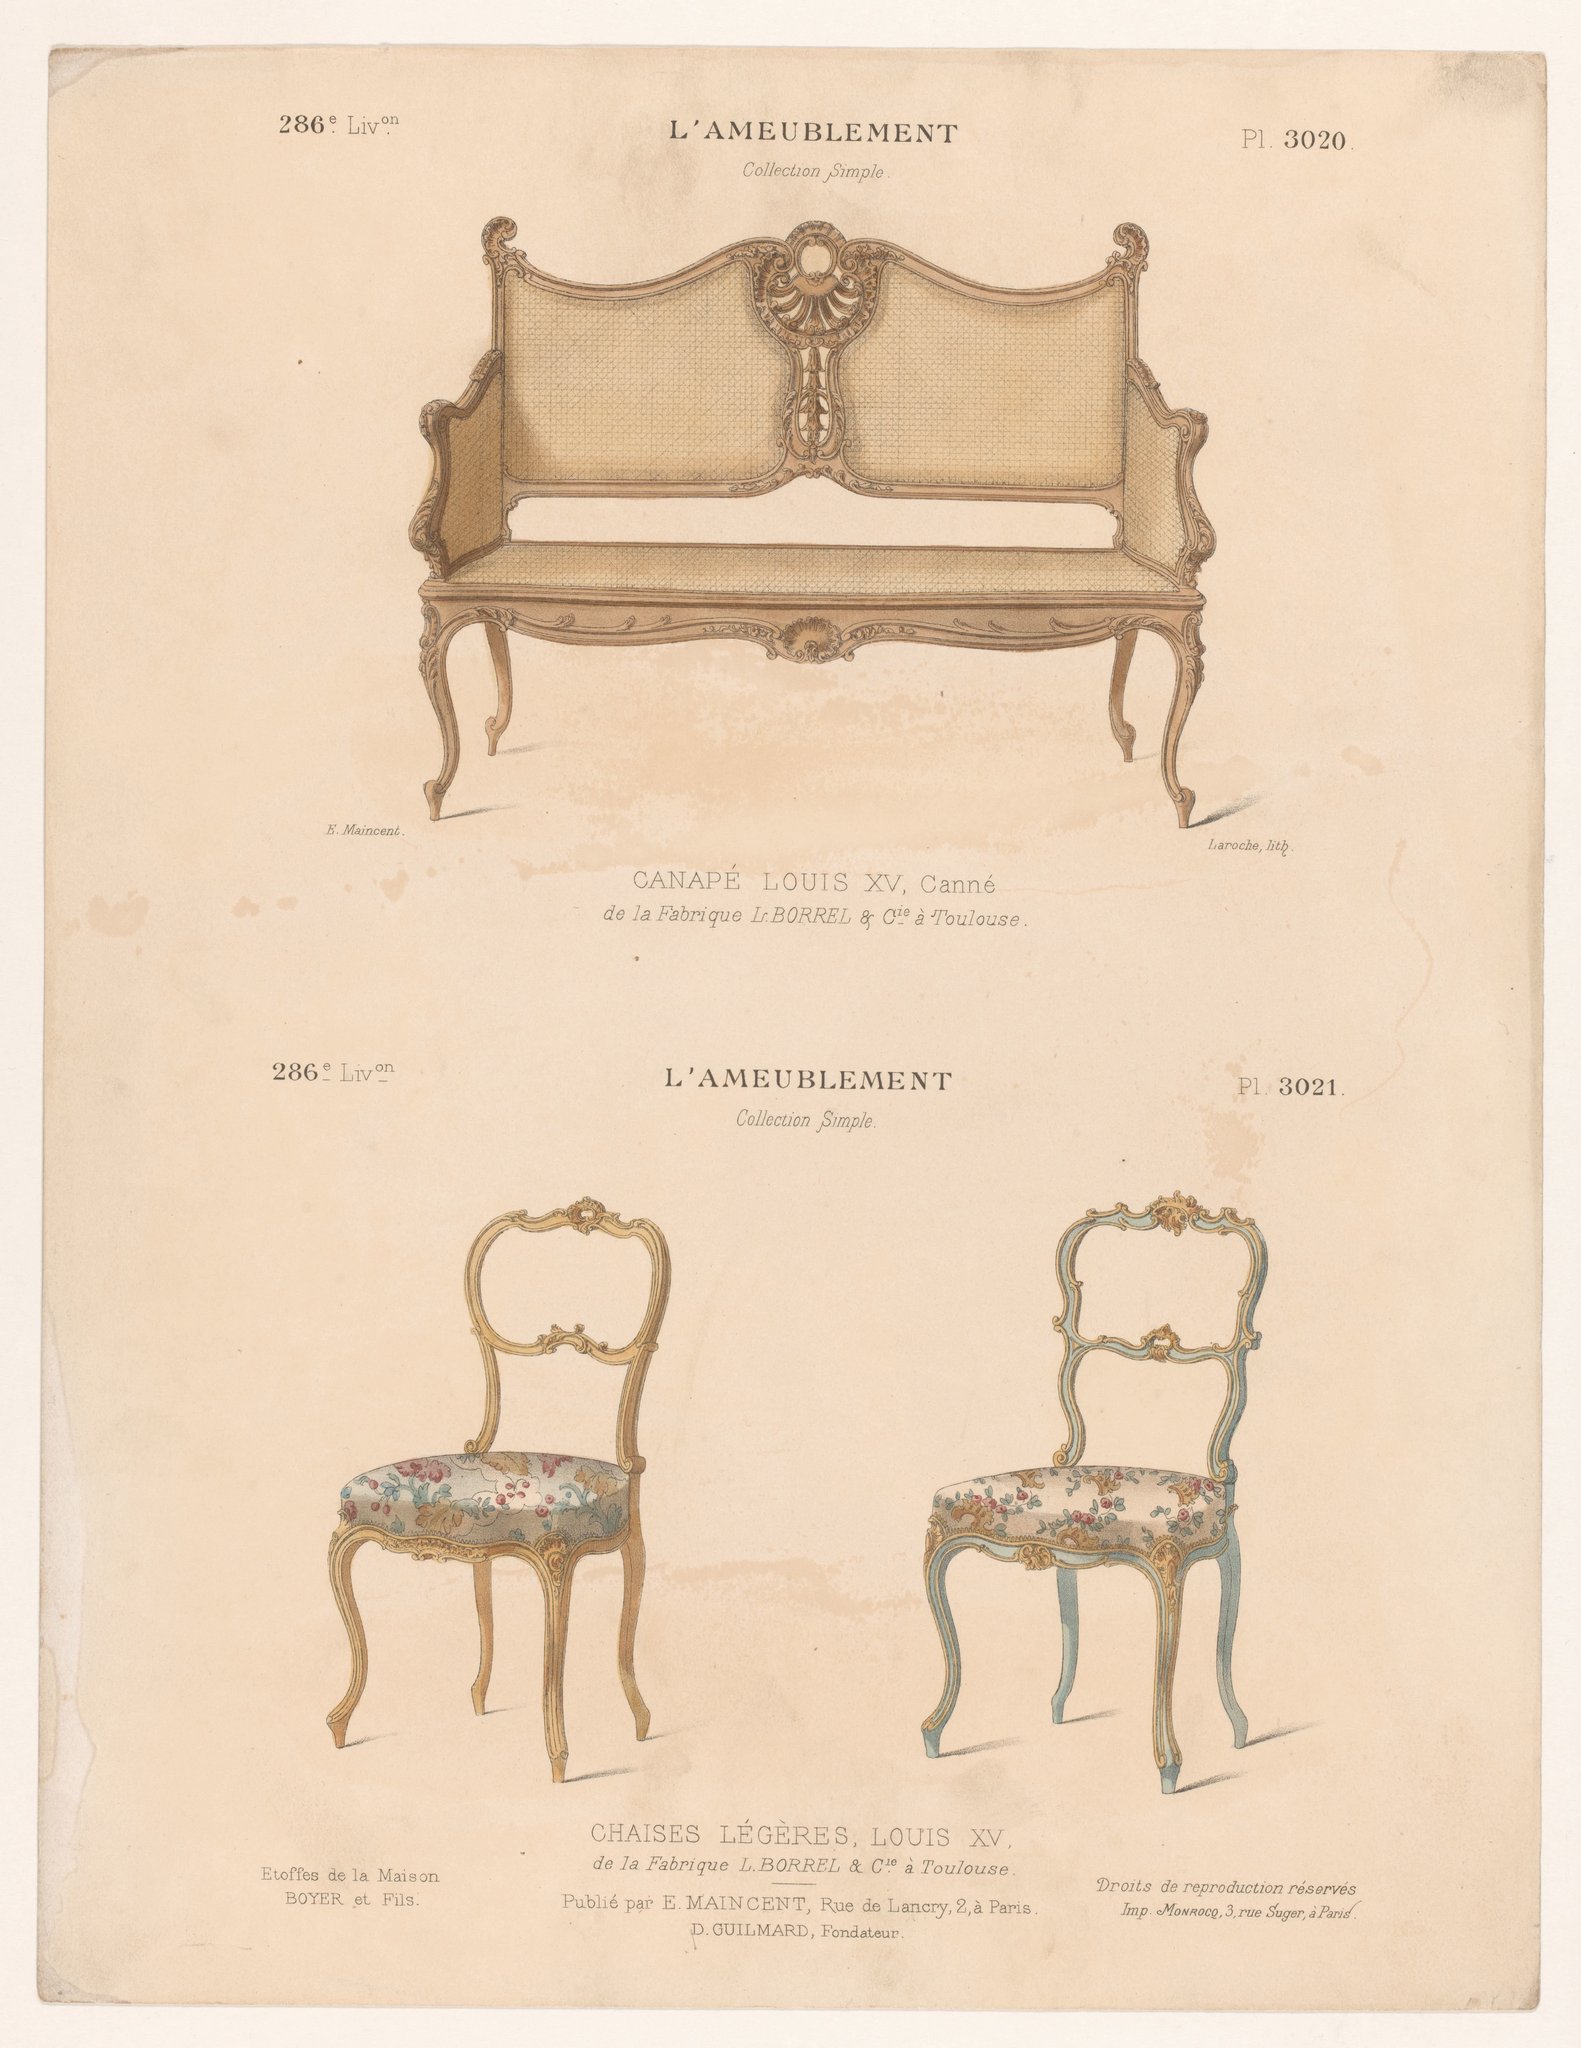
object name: print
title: Canapé Louis XV, Canné / Chaises Légères, Louis XV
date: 1885-1895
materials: paper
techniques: hand coloring, lithograph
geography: paris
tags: seating furniture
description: Een canapé en twee stoelen in de Lodewijk XV-stijl. Prent uit 286e Livraison.